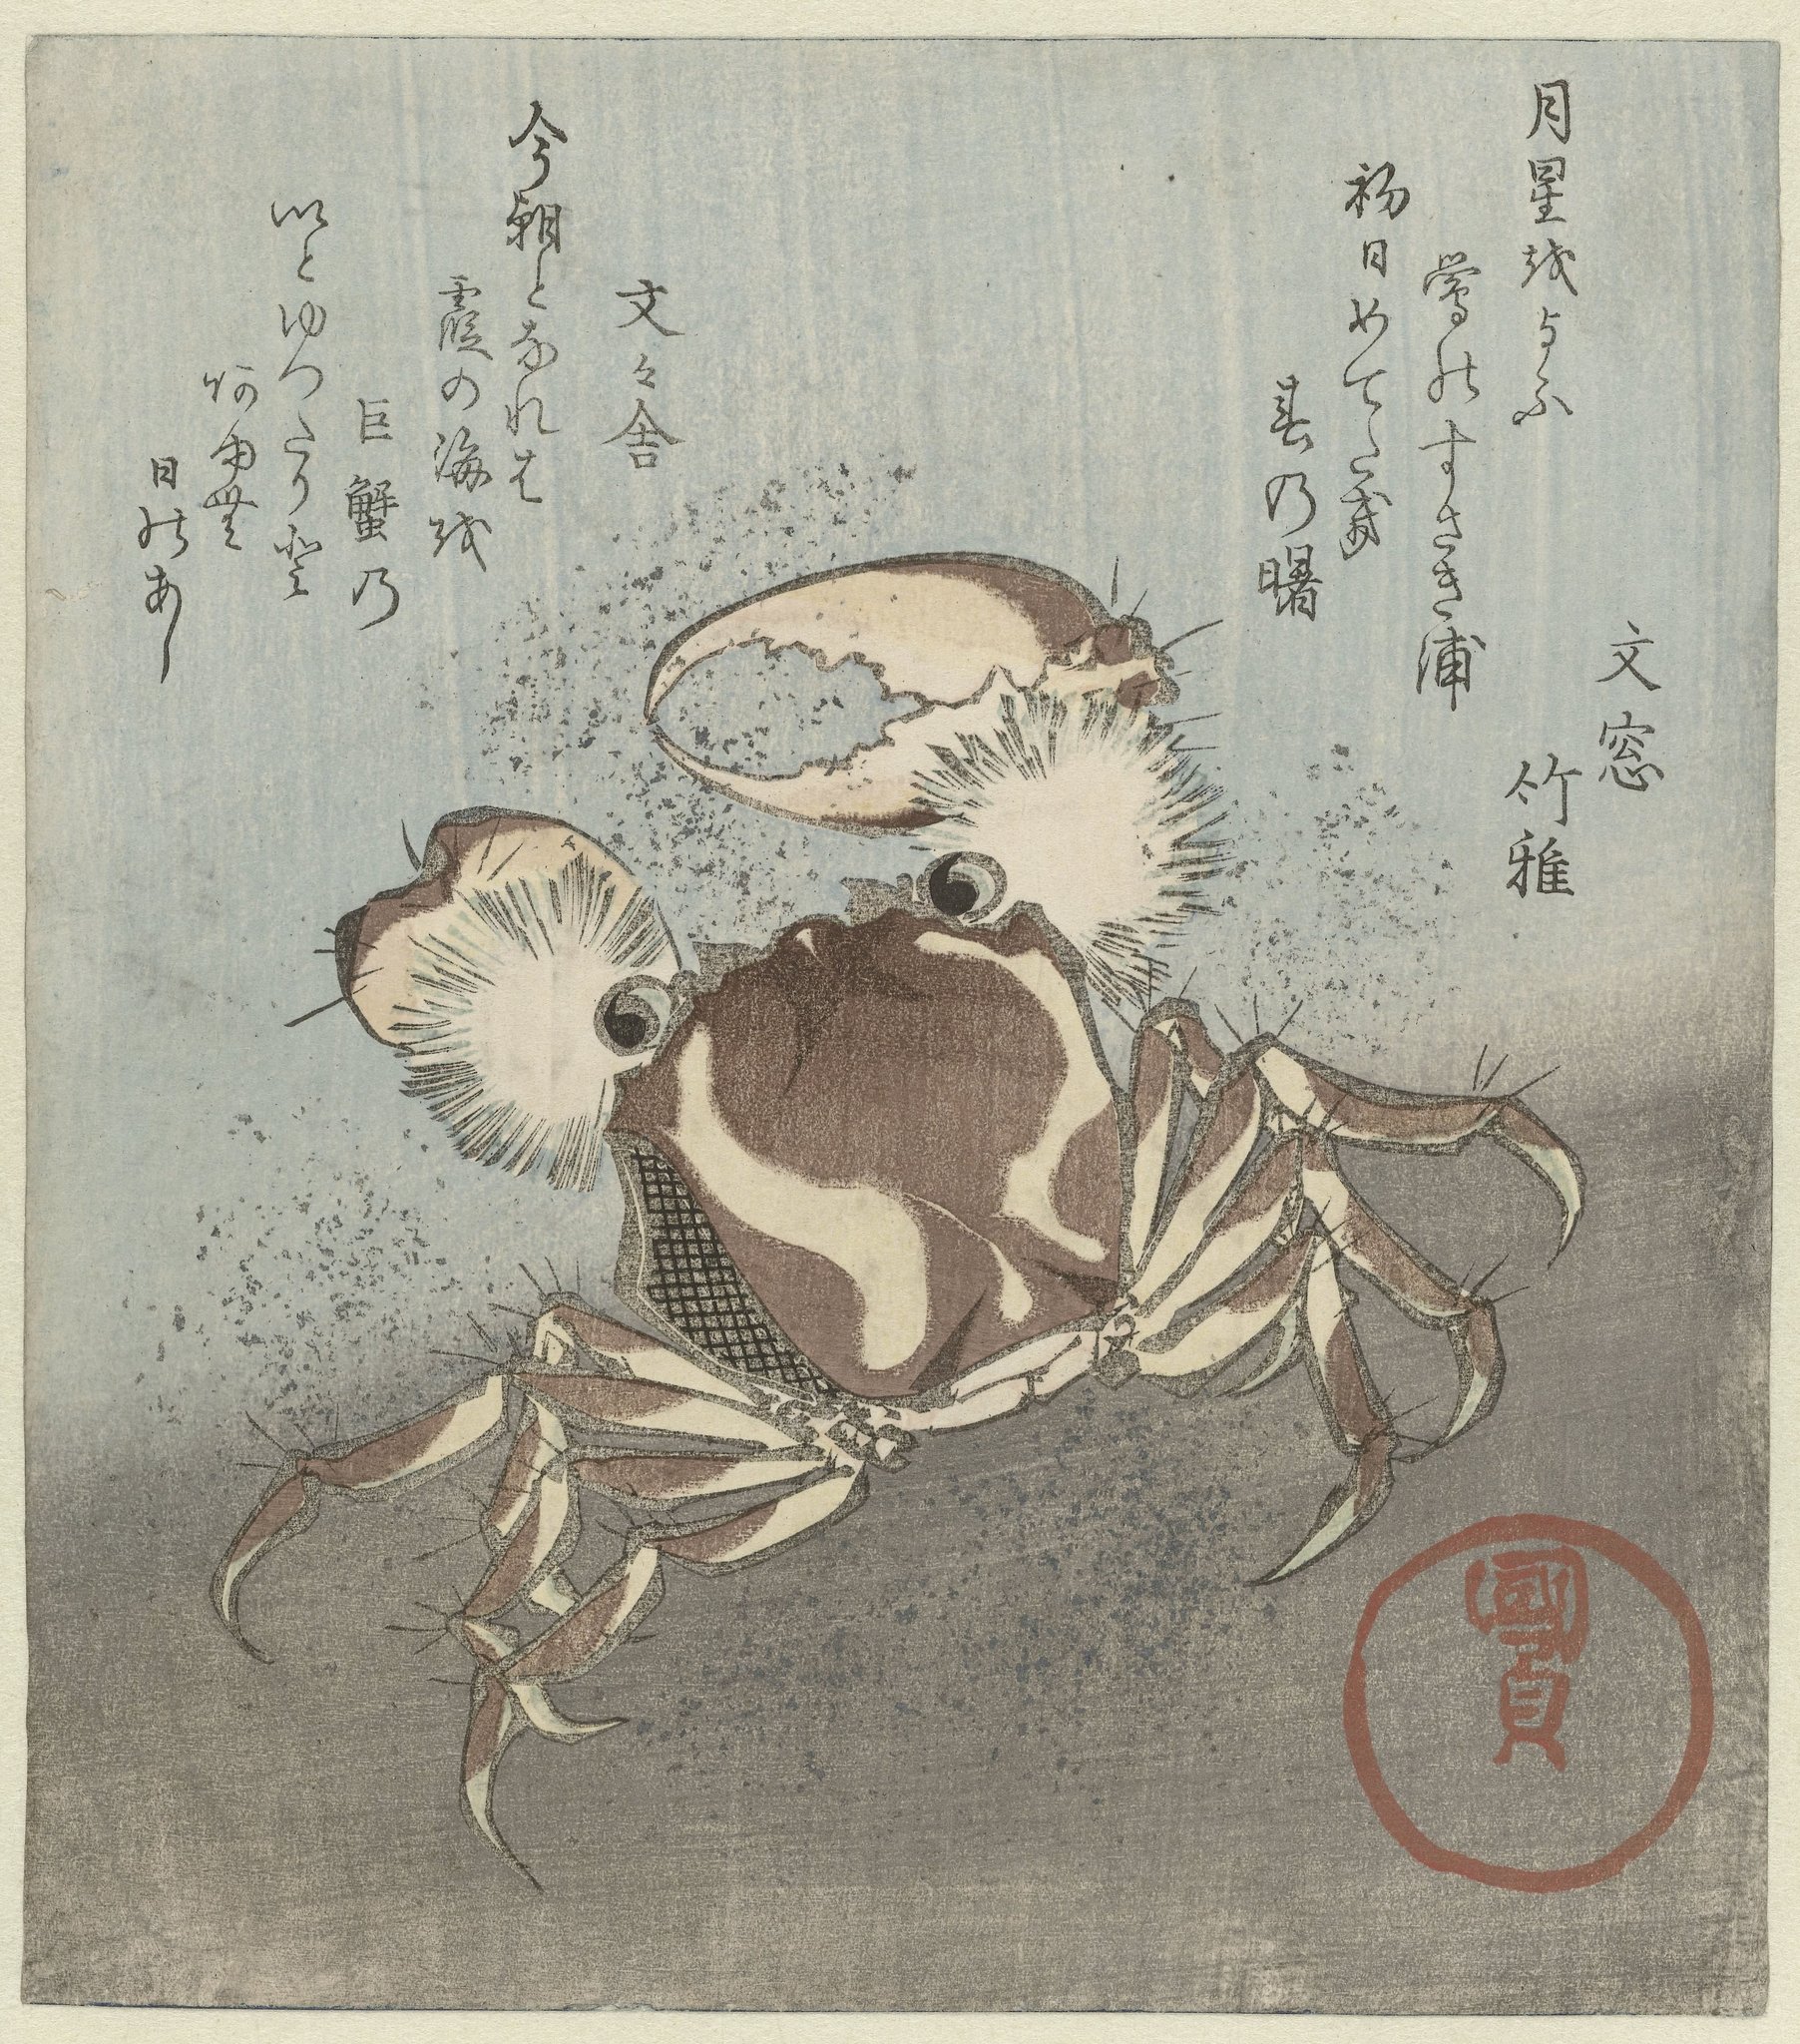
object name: surimono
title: Krab loopt langs water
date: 1822-1827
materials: paper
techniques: woodcut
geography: japan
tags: crustaceans: crab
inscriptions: collector's mark, verso, stamped: Lugt 2760, collector's mark, verso, stamped: Lugt 2228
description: Een surimono is een luxe uitgevoerde prent waarop beeld met één of meerdere gedichten gecombineerd is. Bij het drukken van een surimono werd vaak gebruik gemaakt van dikker papier, blinddruk en metaal pigmenten, zoals koper- en zilverpoeder. De prenten werden vaak in opdracht van dichters gemaakt en als exclusief geschenk aan vrienden en relaties gegeven.